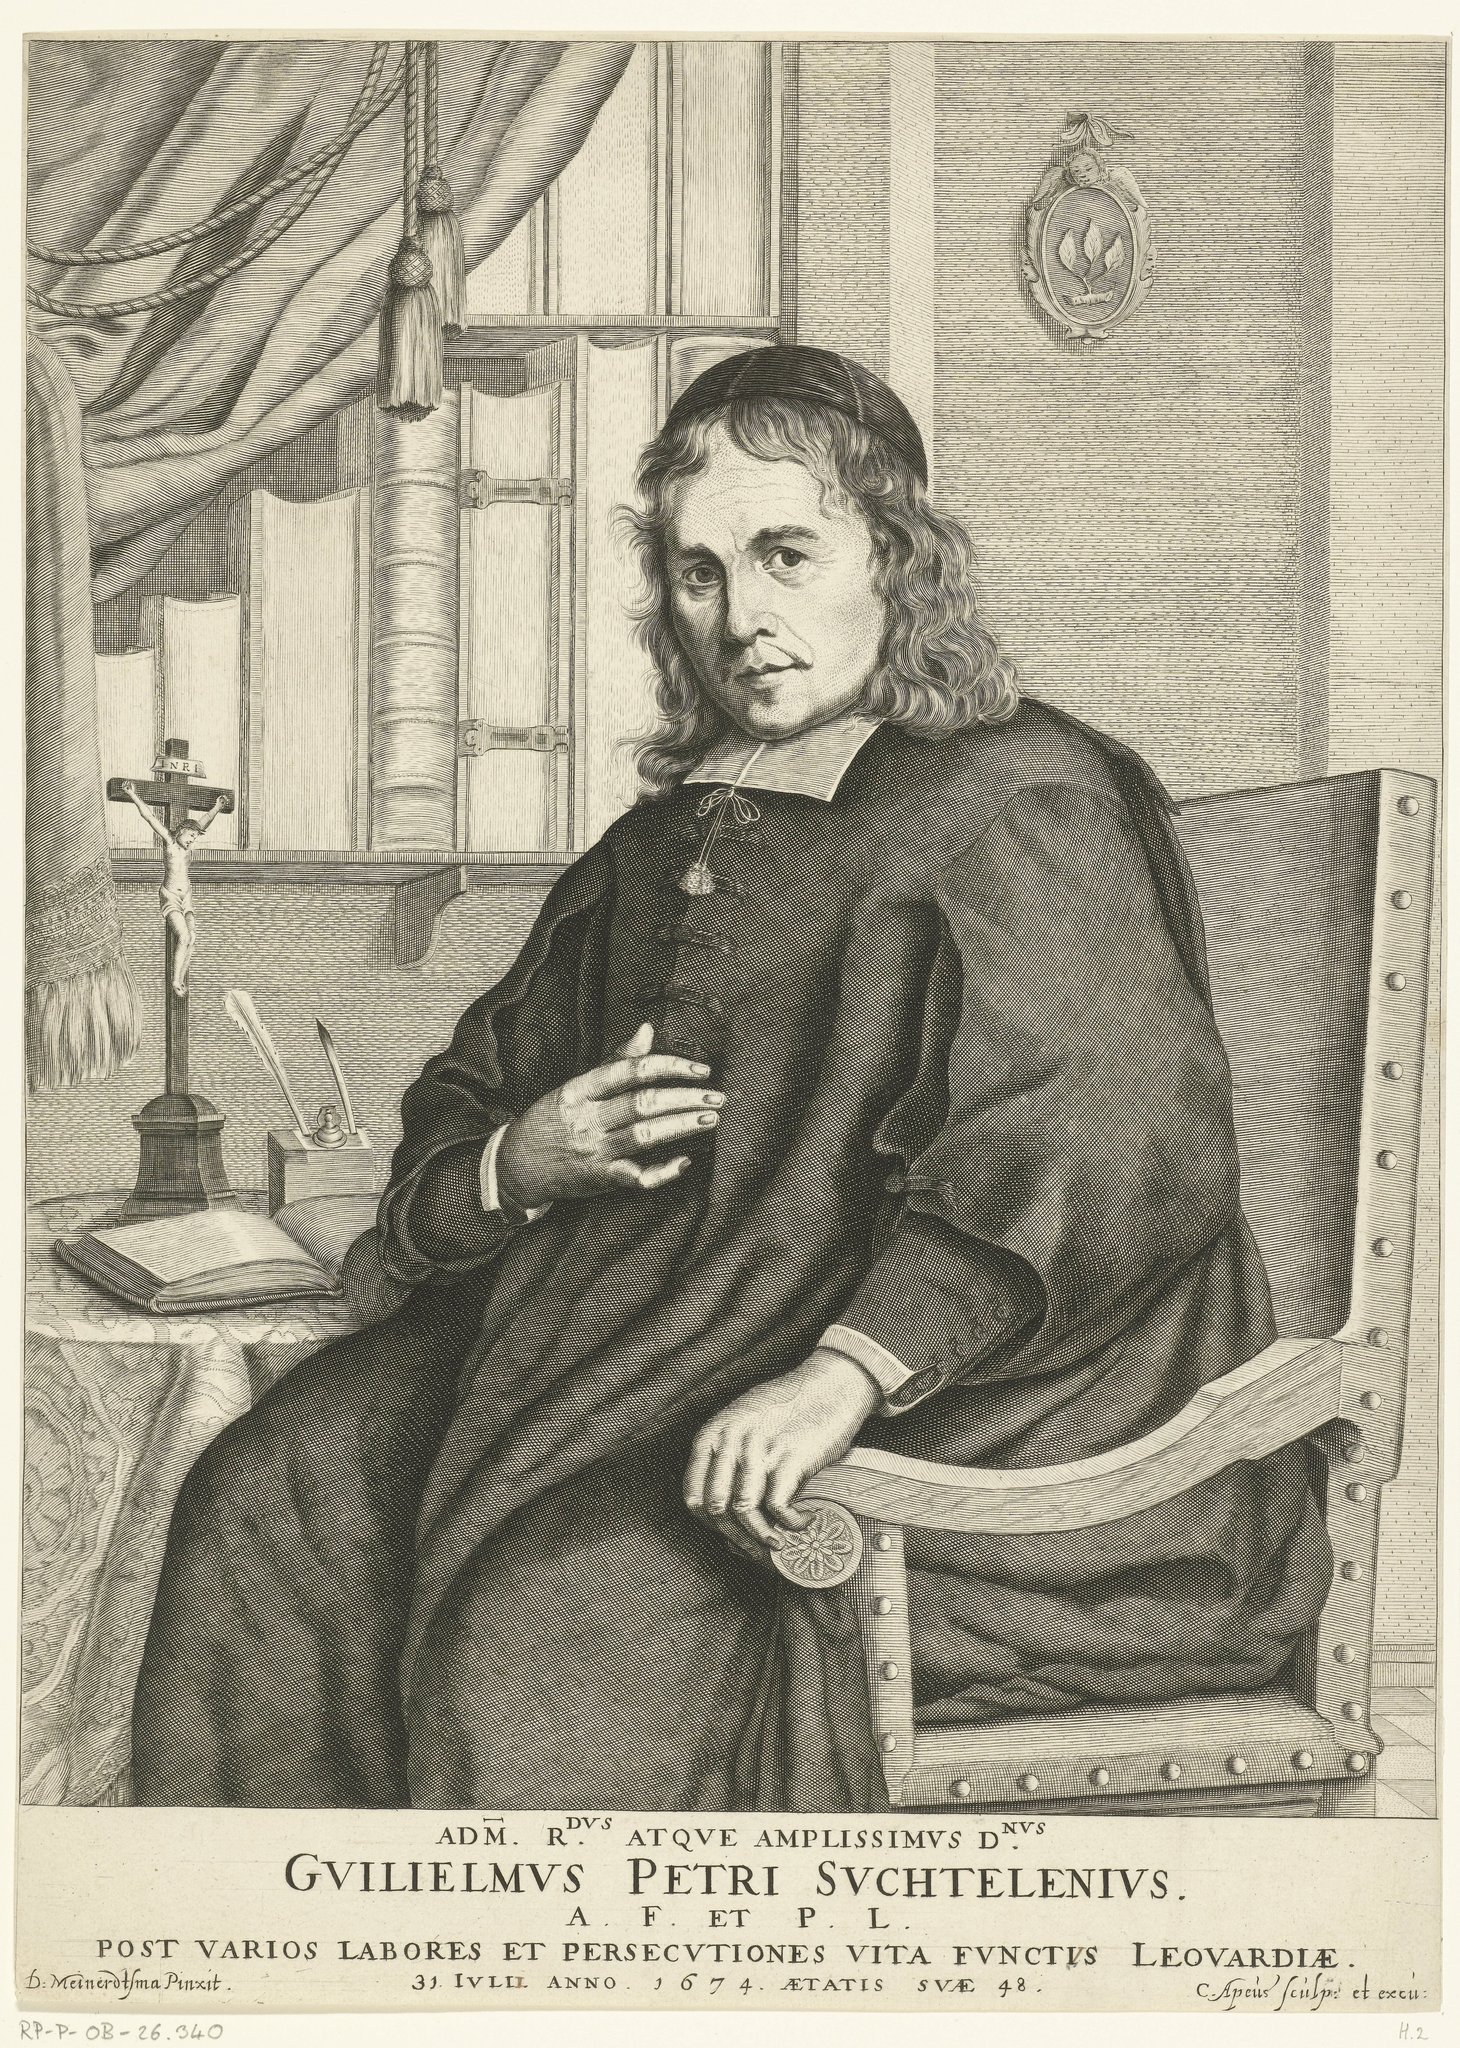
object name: print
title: Portret van Willem Pieter van Suchtelen op 48-jarige leeftijd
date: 1674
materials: paper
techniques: engraving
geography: friesland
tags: theoloog, willem pieter suchtelen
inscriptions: collector's mark: Lugt 2228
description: Willem Pieter van Suchtelen, theoloog uit Leeuwarden, zittend aan een tafel. Op de muur hangt een wapen met een takje met drie bladeren. Onder het portret de namen en titels in het Latijn.